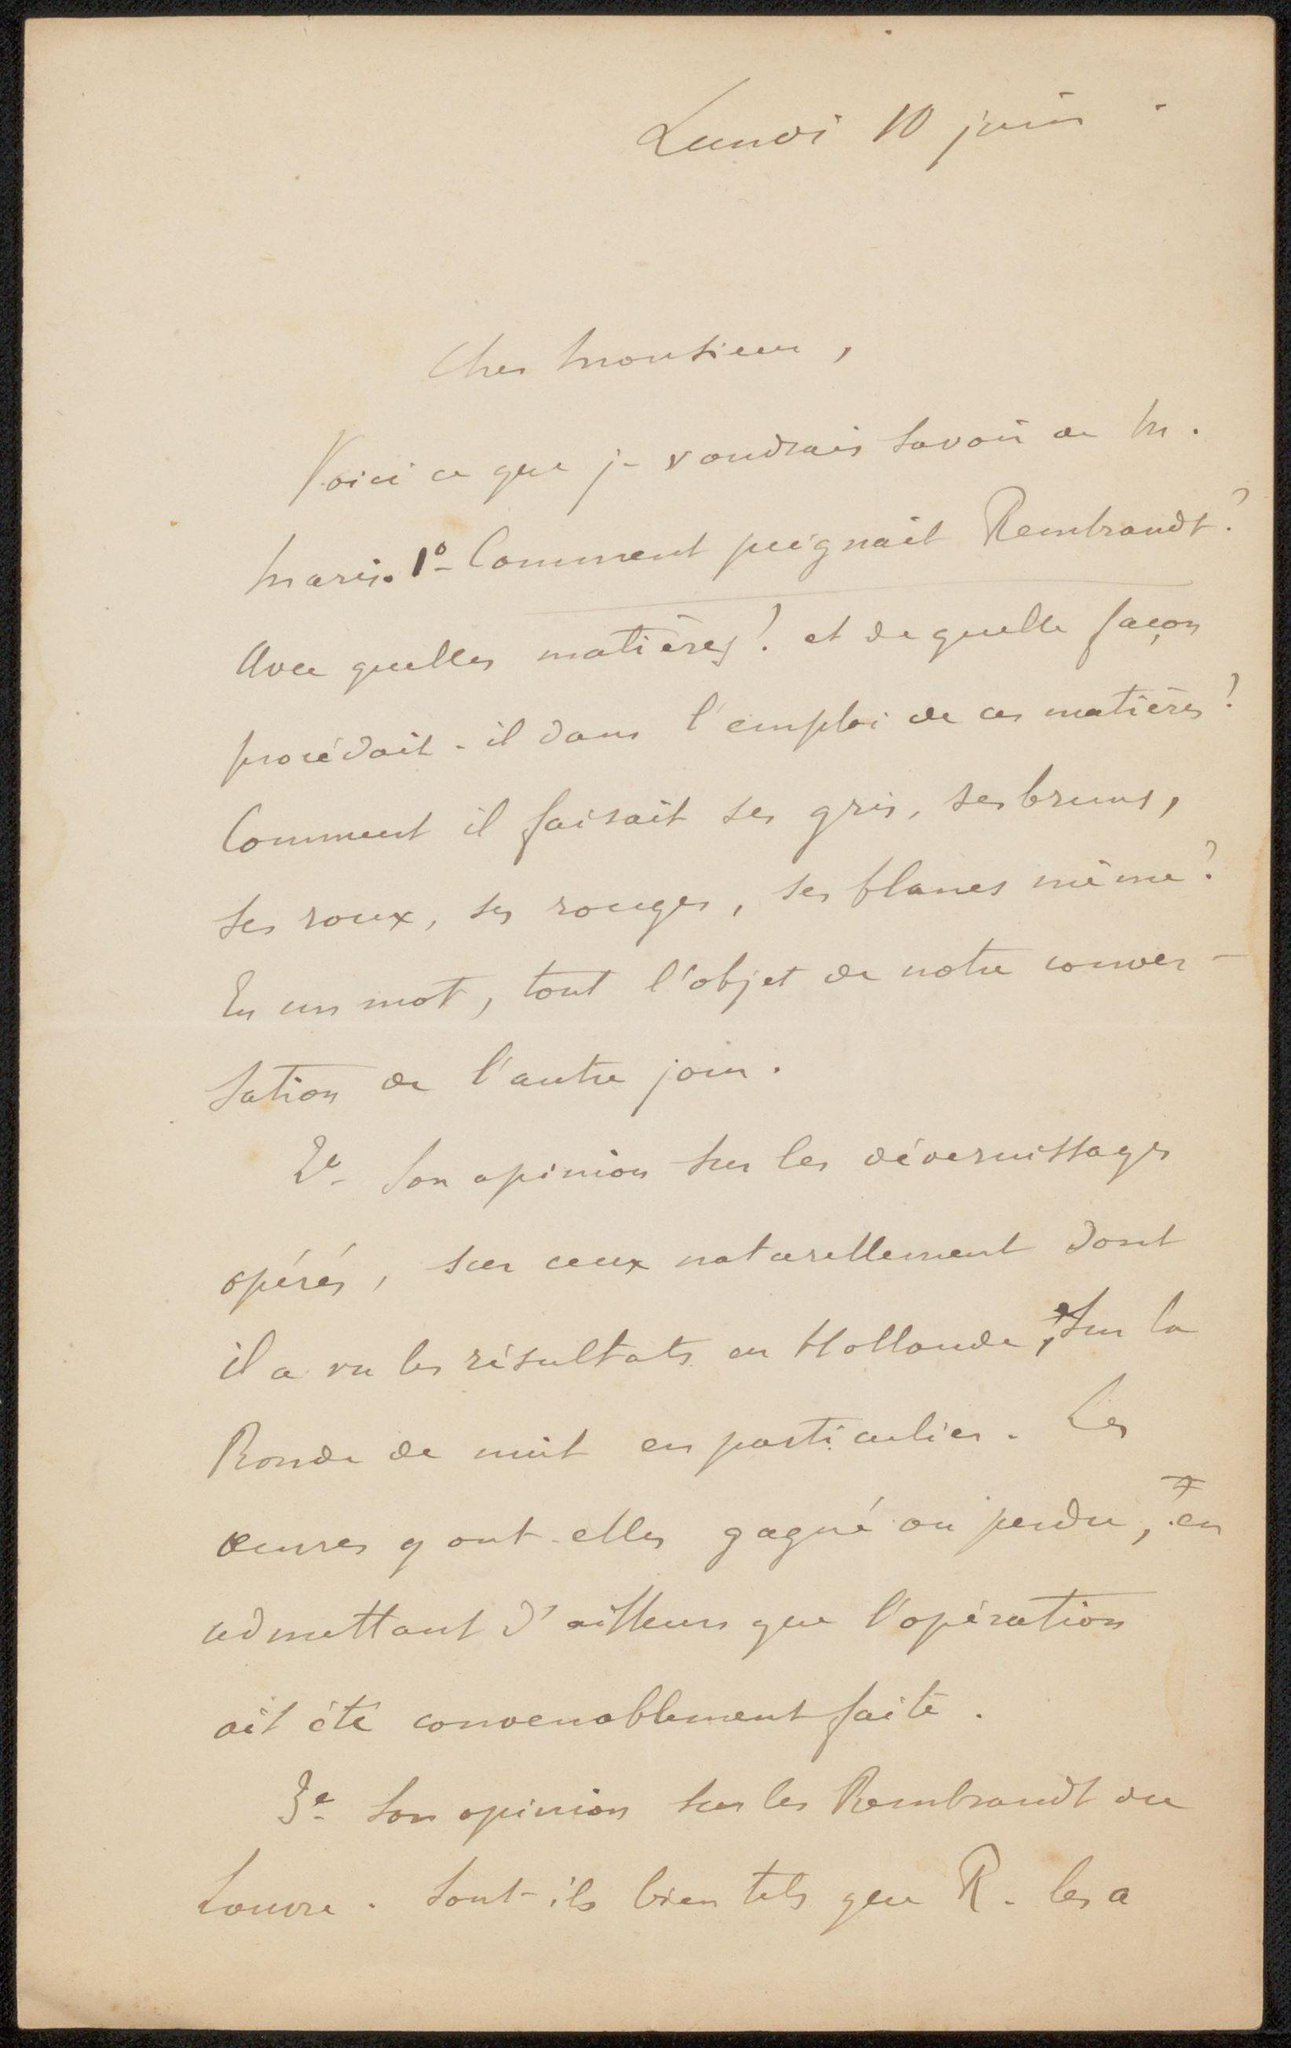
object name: letter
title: Brief aan Philip Zilcken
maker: françois thiébault-sisson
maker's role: kunstcriticus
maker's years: 1856-1944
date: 1897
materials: ink, paper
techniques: pen, writing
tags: the hague, print maker, draughtsman, jacob maris, leiden, rembrandt van rijn, paris, paul verlaine, philip zilcken, painting (including book-illumination, miniature-painting), holland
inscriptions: collector's mark: ‘RPK’